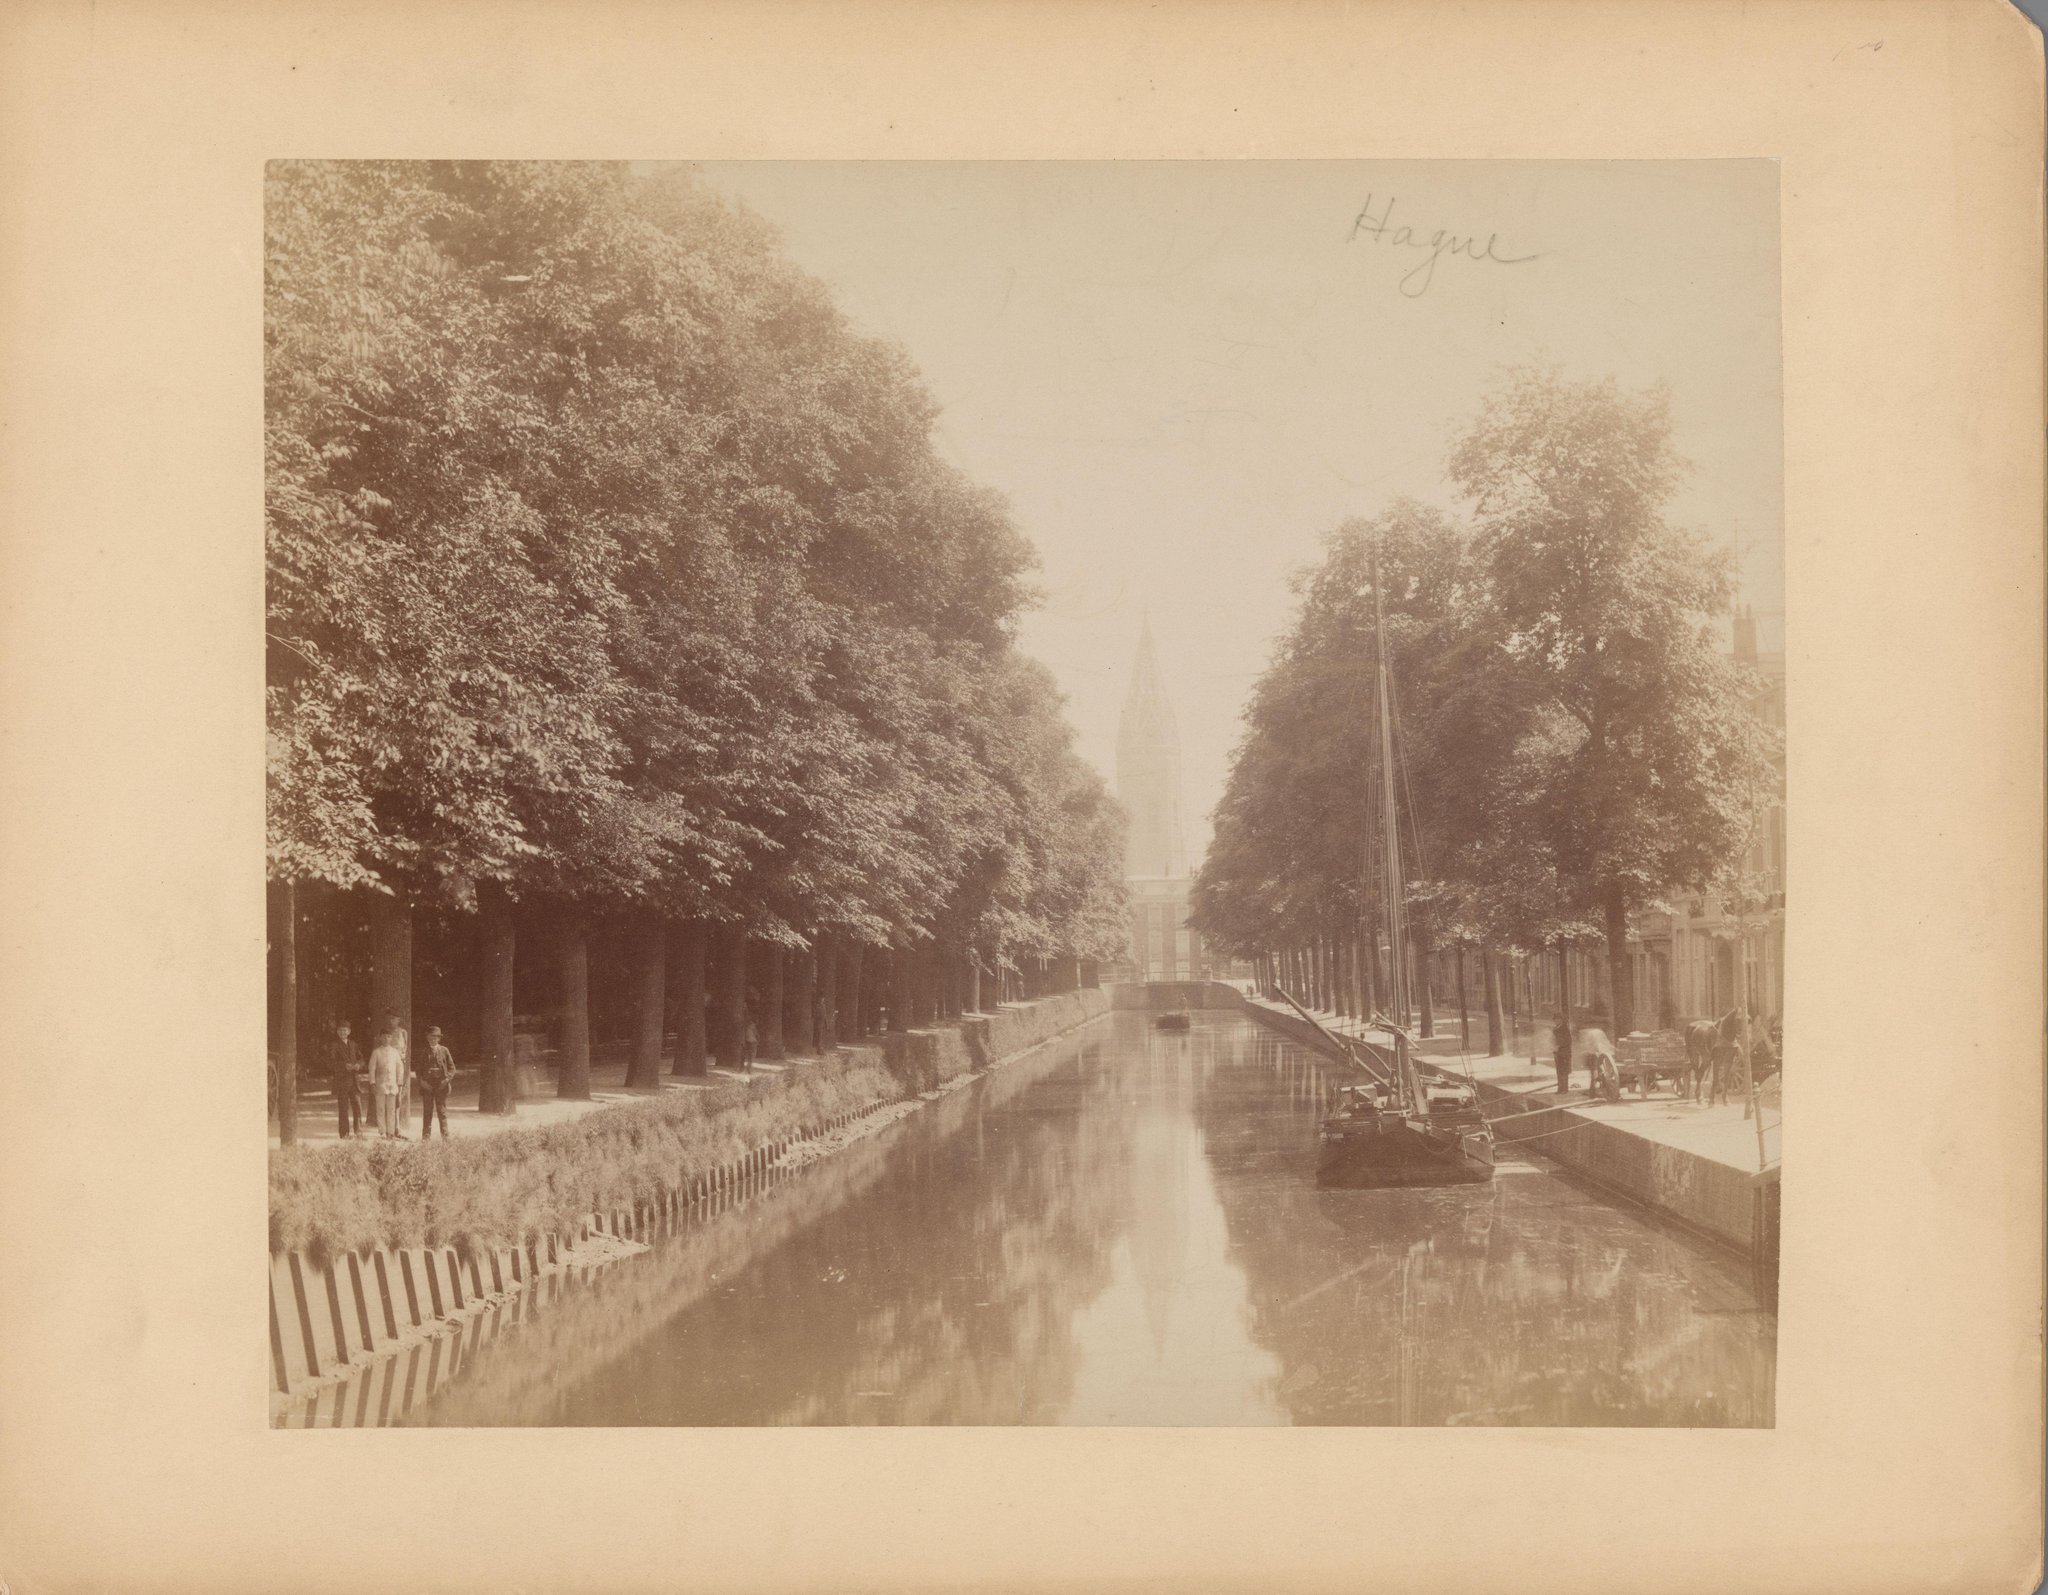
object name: photograph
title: Gezicht op een gracht met kerktoren te Den Haag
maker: Anonymous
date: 1900-1960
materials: cardboard, photographic support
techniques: albumen print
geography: the hague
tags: canals, waters (in city), parts of church exterior and annexes: tower, the hague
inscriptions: annotation: ‘Geschonken door de Historical Society of Western Pennsylvania, Pittsburgh/ 1990’, annotation: ‘Hague’